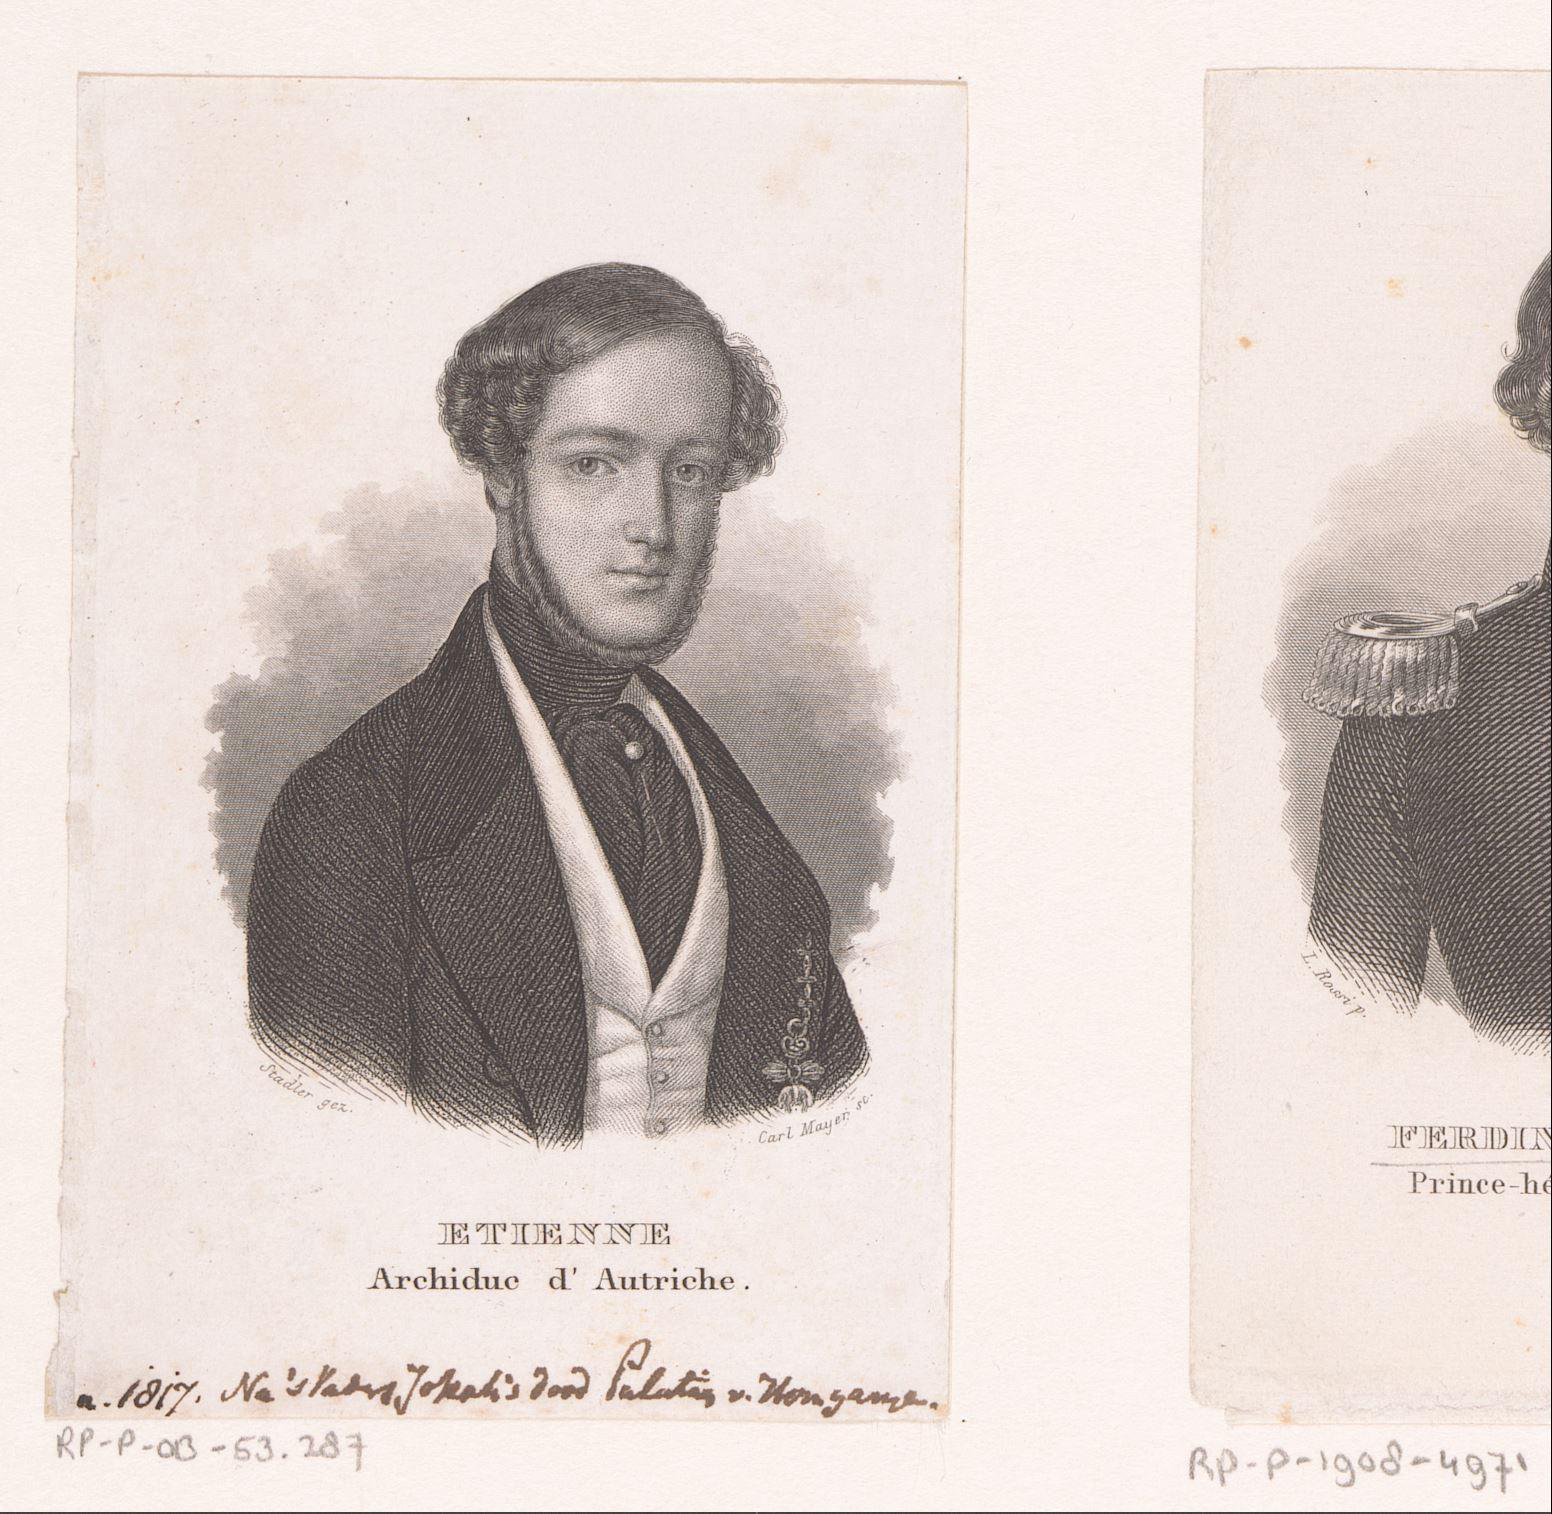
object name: print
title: Portret van Stephan Franz Viktor, aartshertog van Oostenrijk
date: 1844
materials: paper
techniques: engraving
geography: nuremberg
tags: historical persons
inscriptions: collector's mark: Lugt 2228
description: Vermoedelijk afkomstig uit: Almanach de Gotha, 1844.